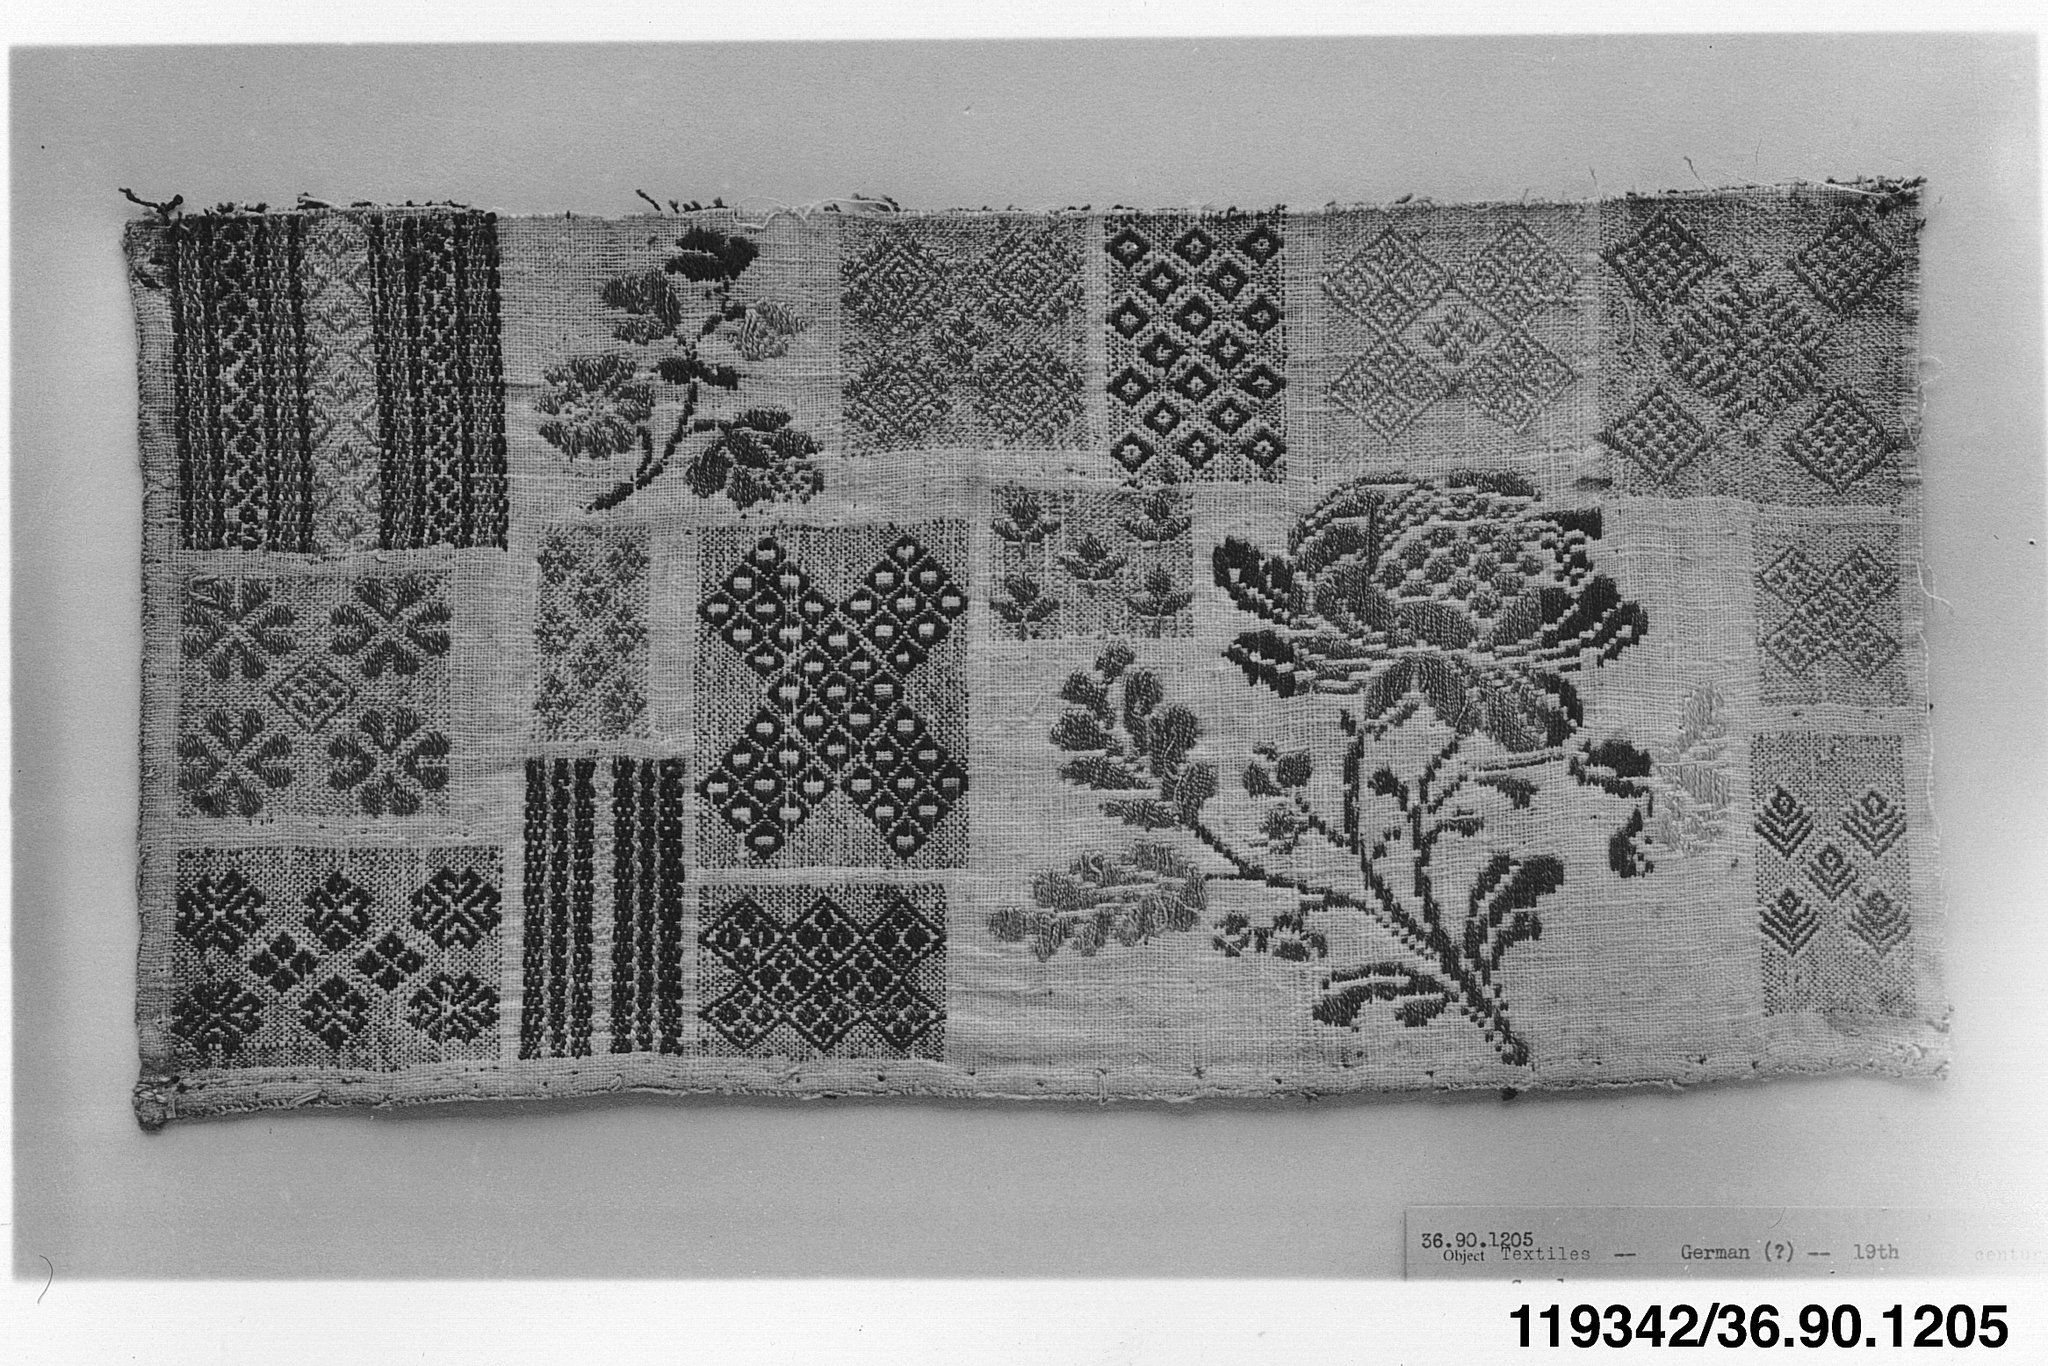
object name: sampler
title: Embroidered darning sampler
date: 1801-1900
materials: linen, silk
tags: flowers